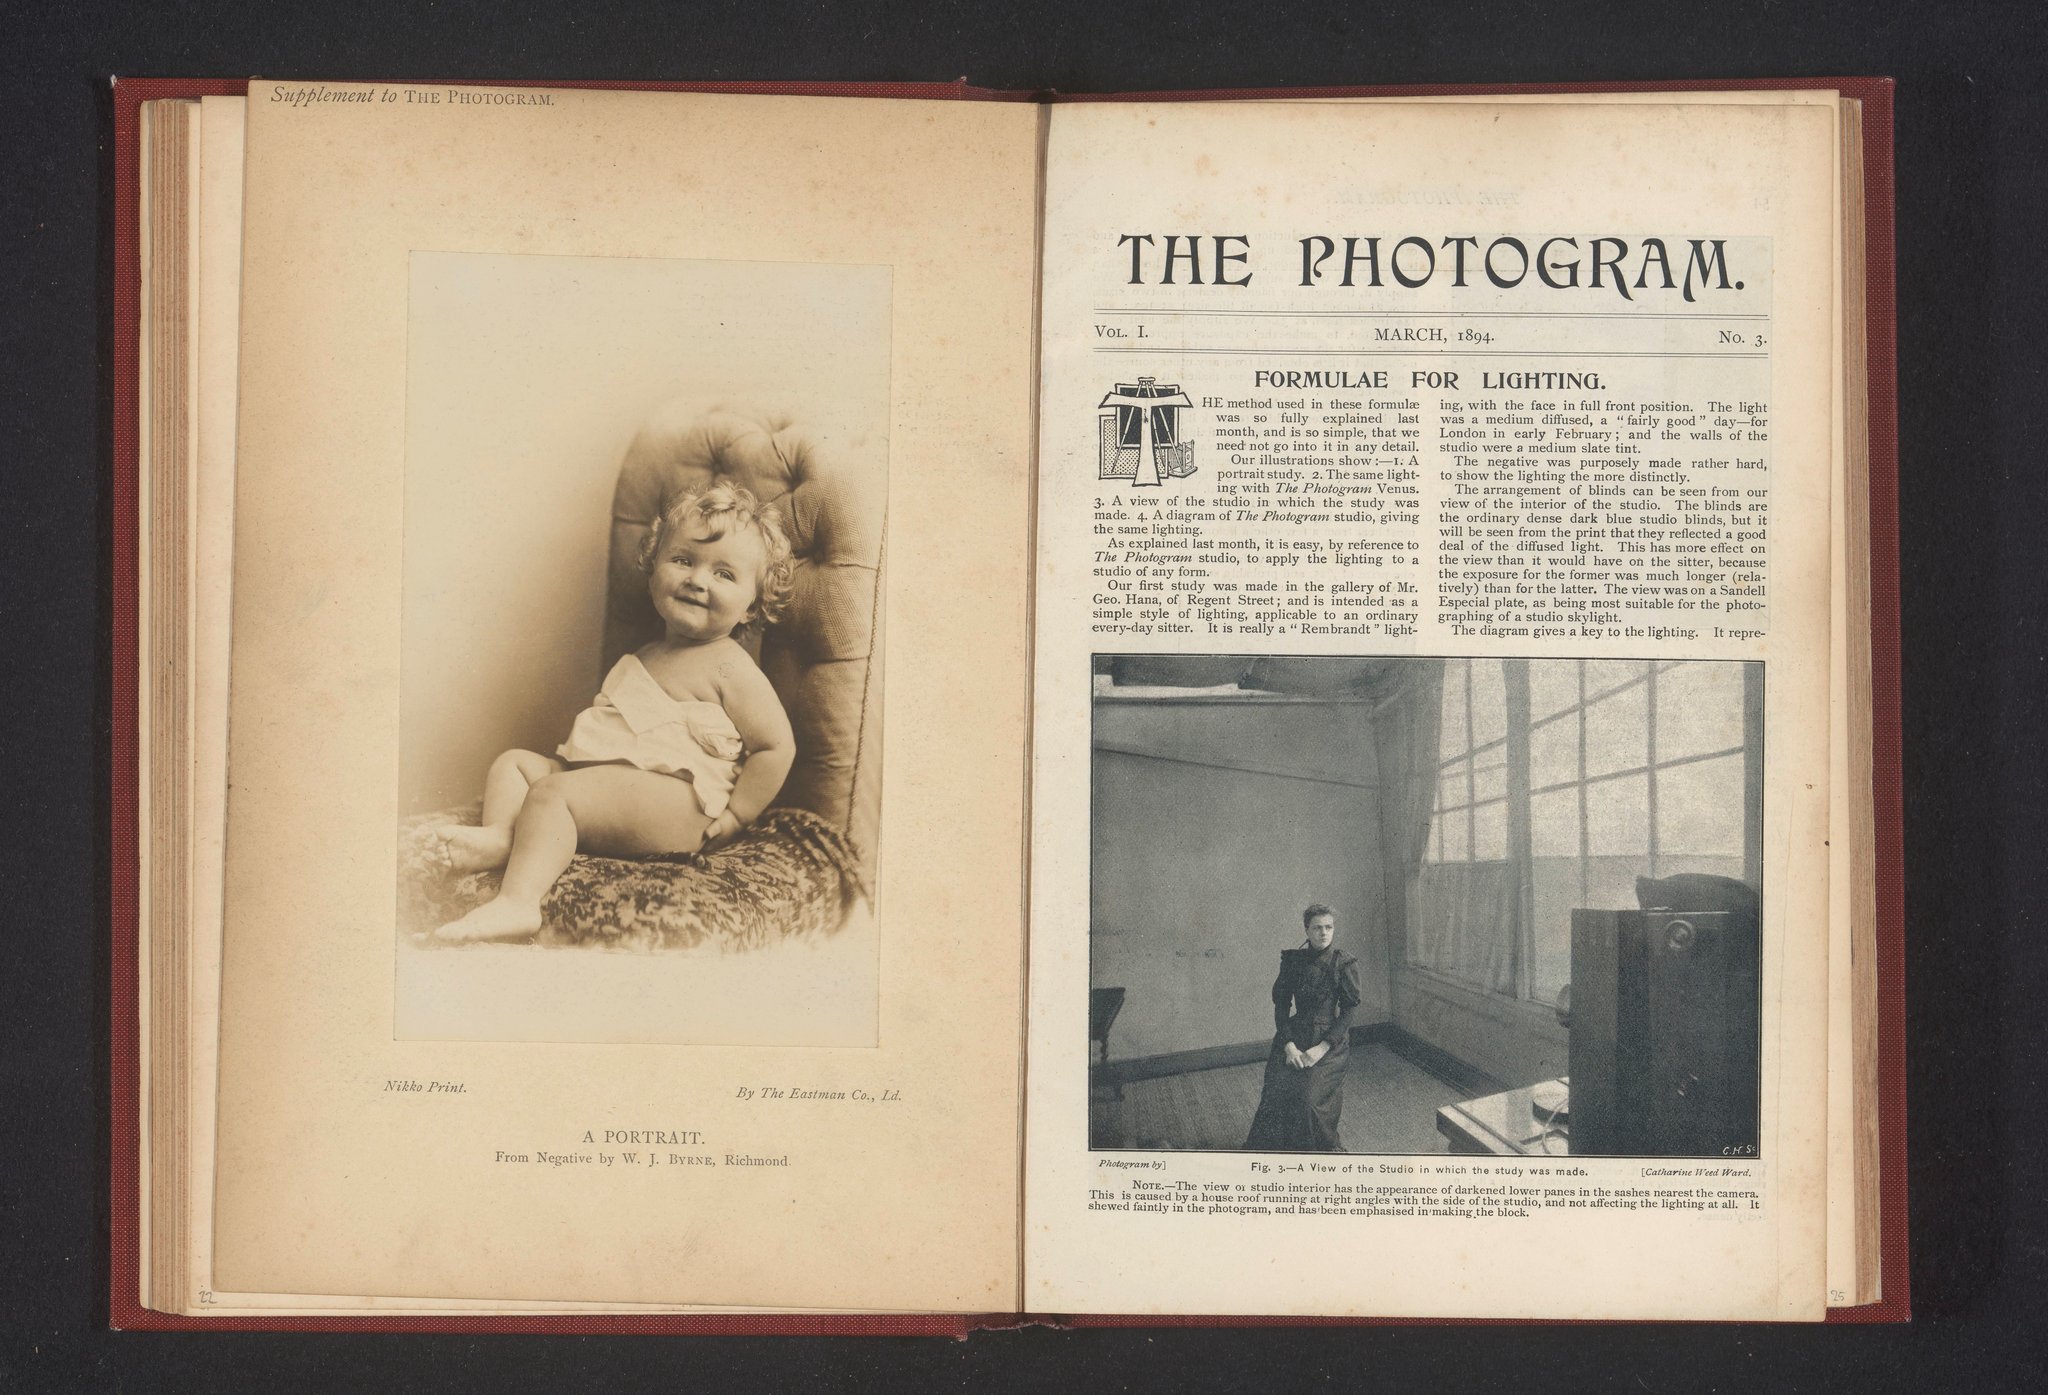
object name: photomechanical print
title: Portret van een onbekend kind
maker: william joseph byrne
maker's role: fotograaf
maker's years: 1843-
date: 1889-1894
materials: paper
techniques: gelatin silver print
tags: toddler